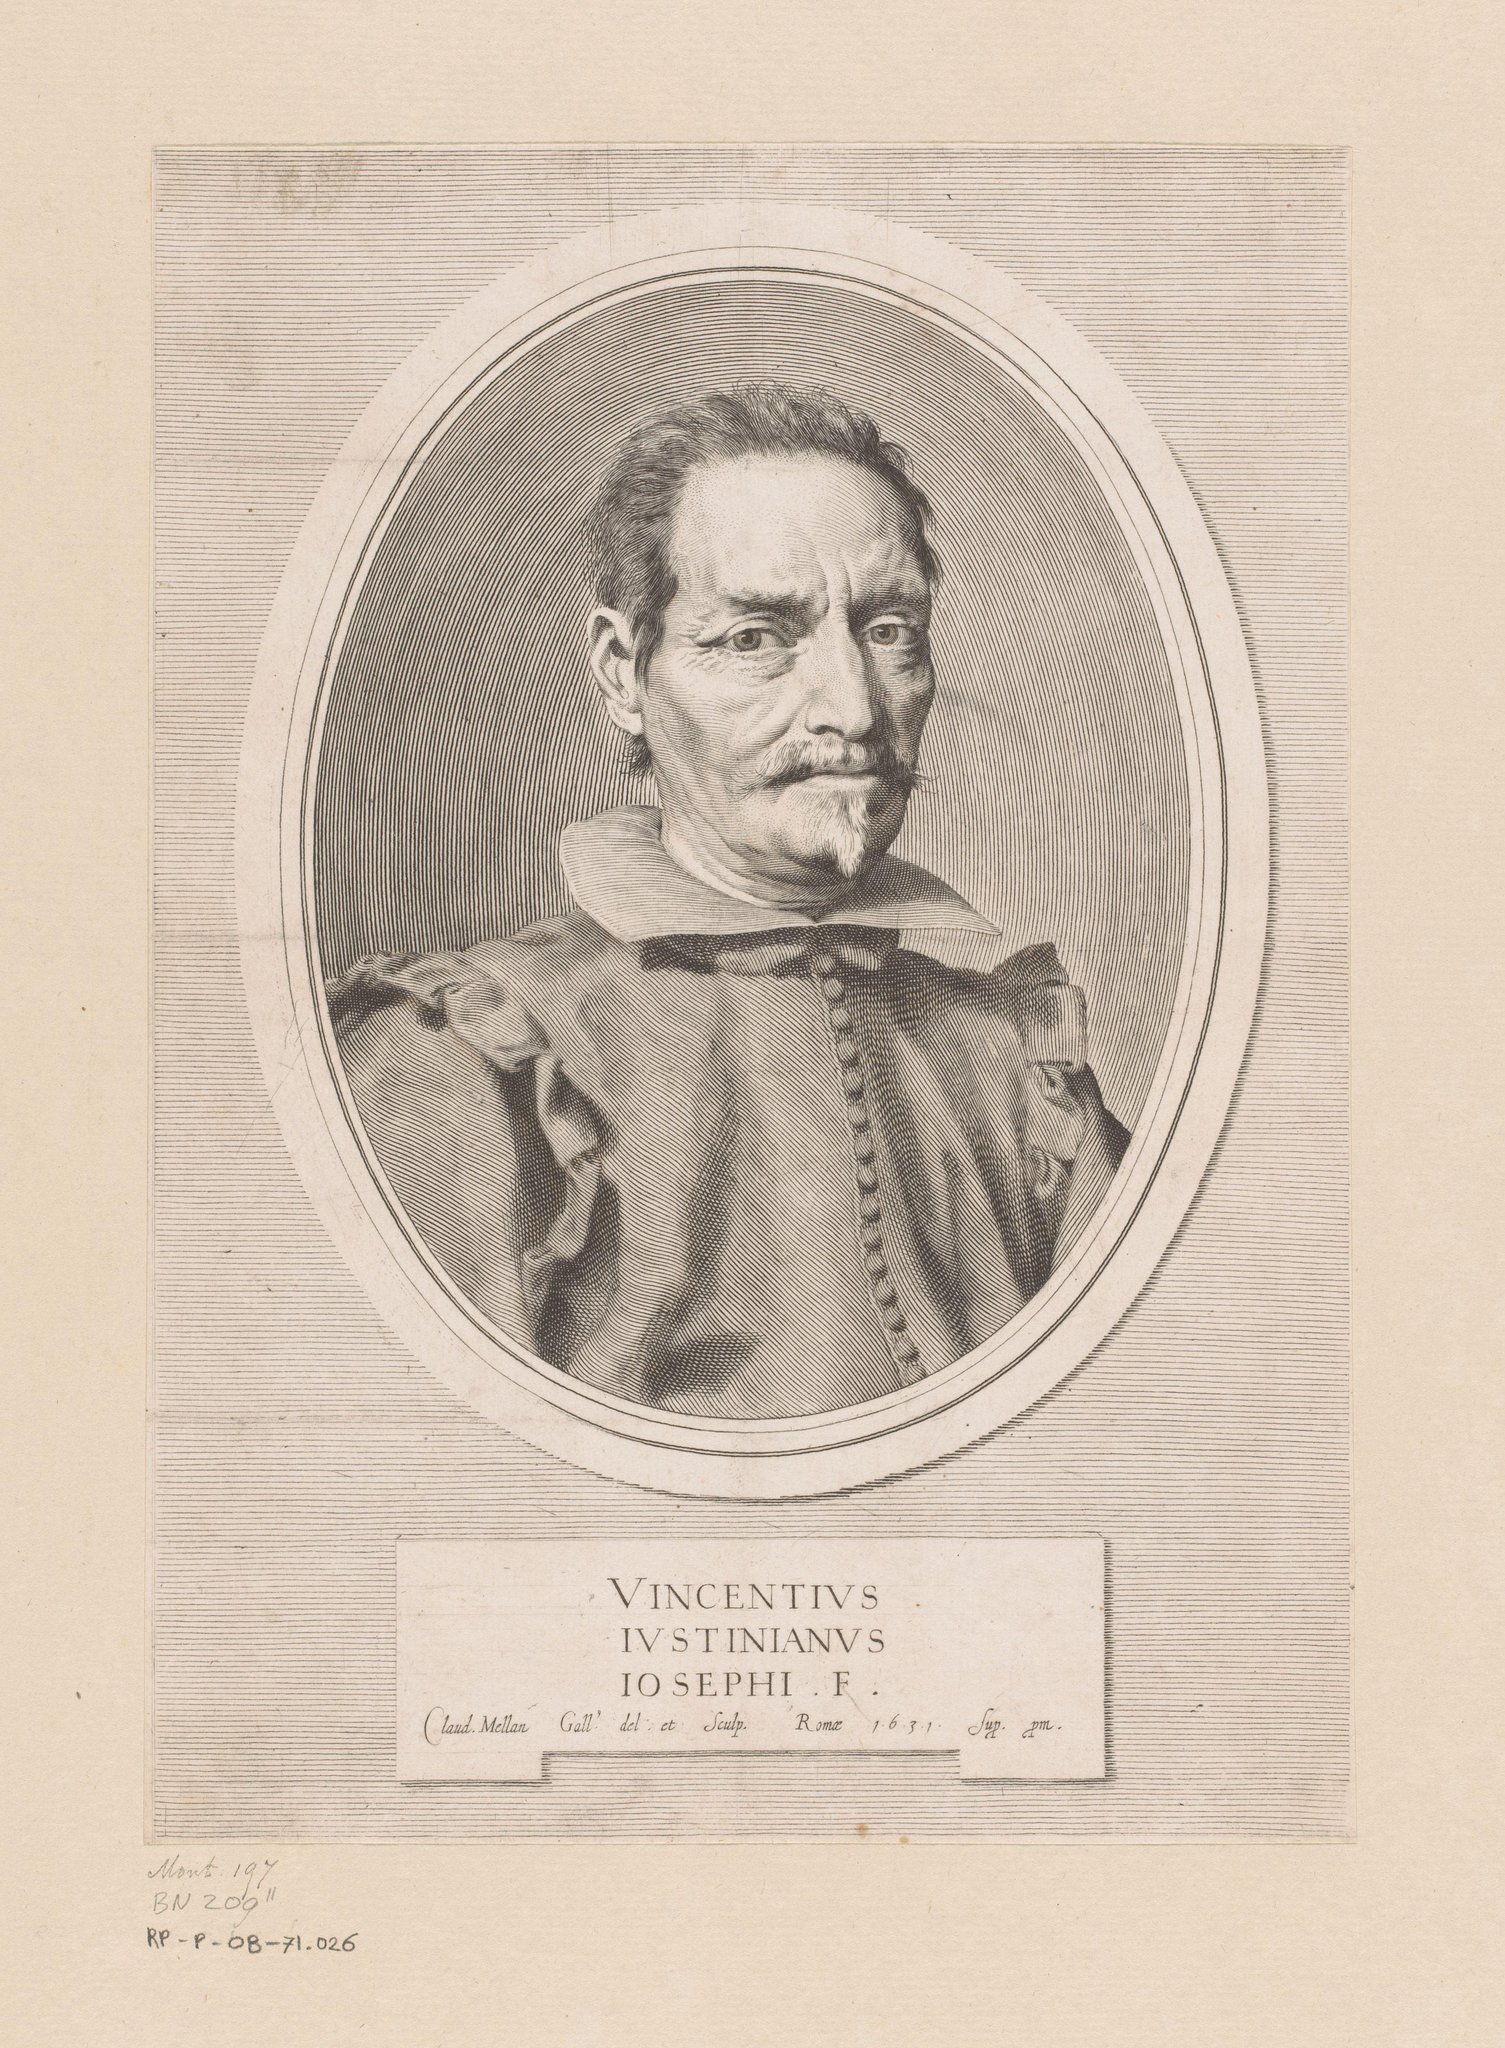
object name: print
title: Portret van Vincenzo Giustiniani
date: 1631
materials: paper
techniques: engraving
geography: italy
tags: rome, vincenzo giustiniani (1564-1637), historical persons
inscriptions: collector's mark: Lugt 240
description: Maakt deel uit van een serie bestaande uit 322 prenten van kunstwerken uit de collectie van Vincenzo Giustiniani die in twee volumes werd uitgegeven door Joachim von Sandrart in 1636 en 1637 (zie British Museum, inv.nr. 1851,1213.565). De serie bestaat uit prenten door verschillende kunstenaars zoals Cornelis Bloemaert, Theodore Matham, Pieter de Bailliu en Michel Natalis. Claude Mellan was verantwoordelijk voor 22 prenten van standbeelden en het 1631 gedateerde portret van Giustiniani. De voorbereidende tekening bevindt zich in de collectie van de Albertina te Wenen, inv.nr. 11471.